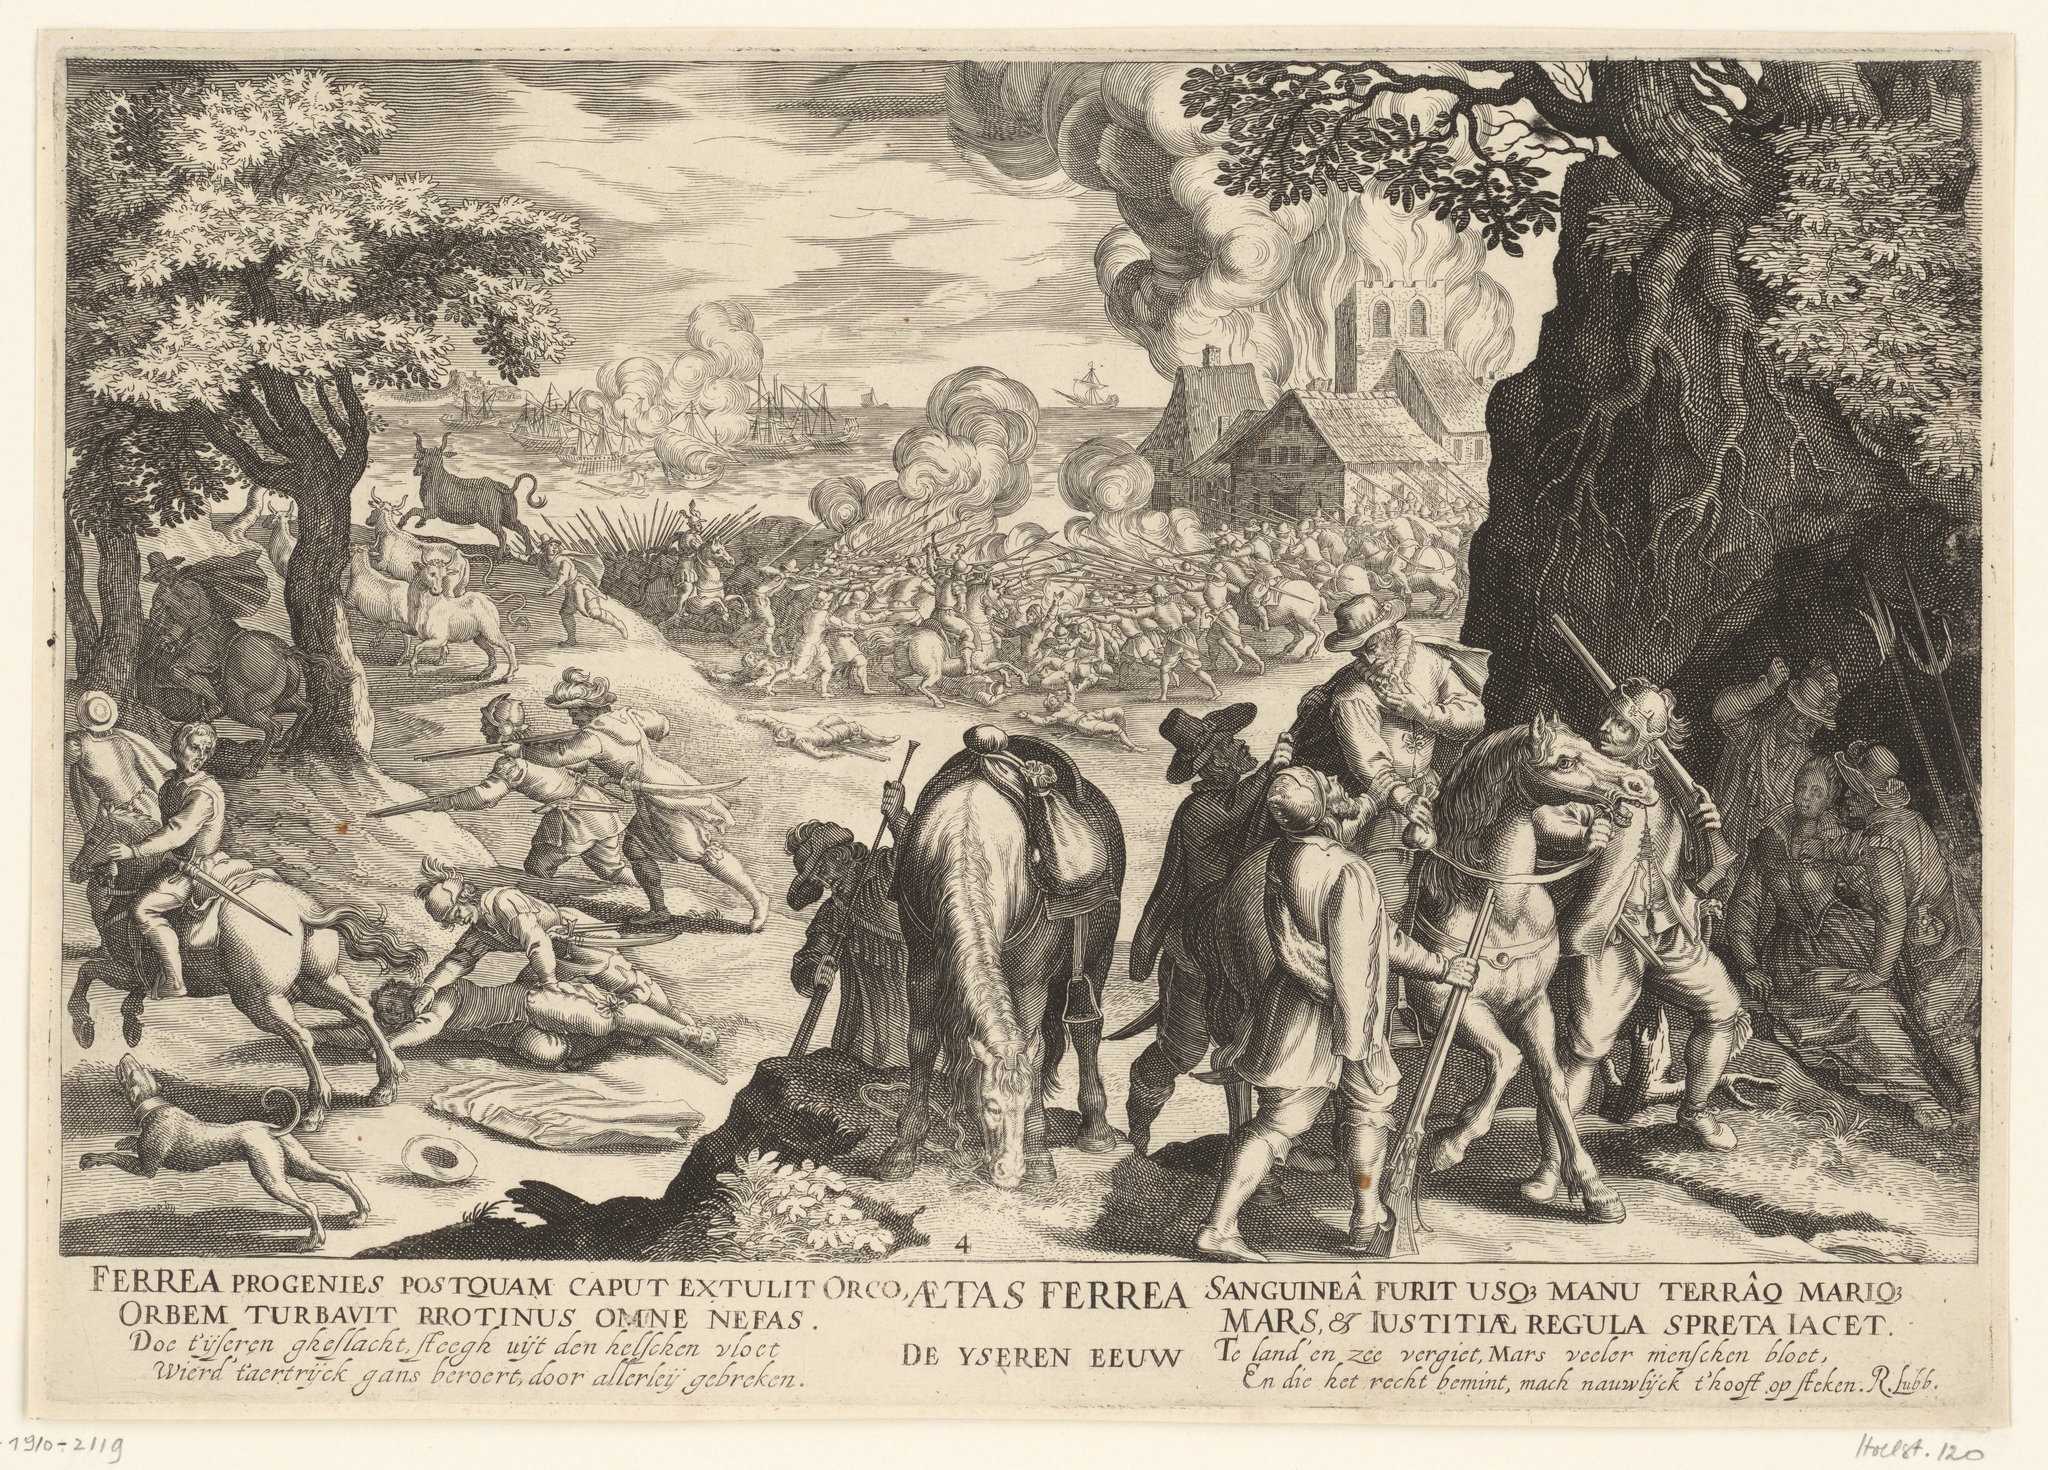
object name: print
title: Het ijzeren tijdperk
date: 1591-1659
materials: paper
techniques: engraving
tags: war, the iron age, 'aetas ferrea'; characterized by mars, war and rapine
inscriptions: collector's mark: Lugt 2228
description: Het ijzeren tijdperk: mensen voeren oorlog. Gezicht op een slagveld met gevecht, op de achtergrond een zeegevecht en een brandende stad. Onder de prent een vers in het Latijn en Nederlands van vier regels. Prent uit een serie van vier prenten met landschappen die de tijdperken van de wereld verbeelden.